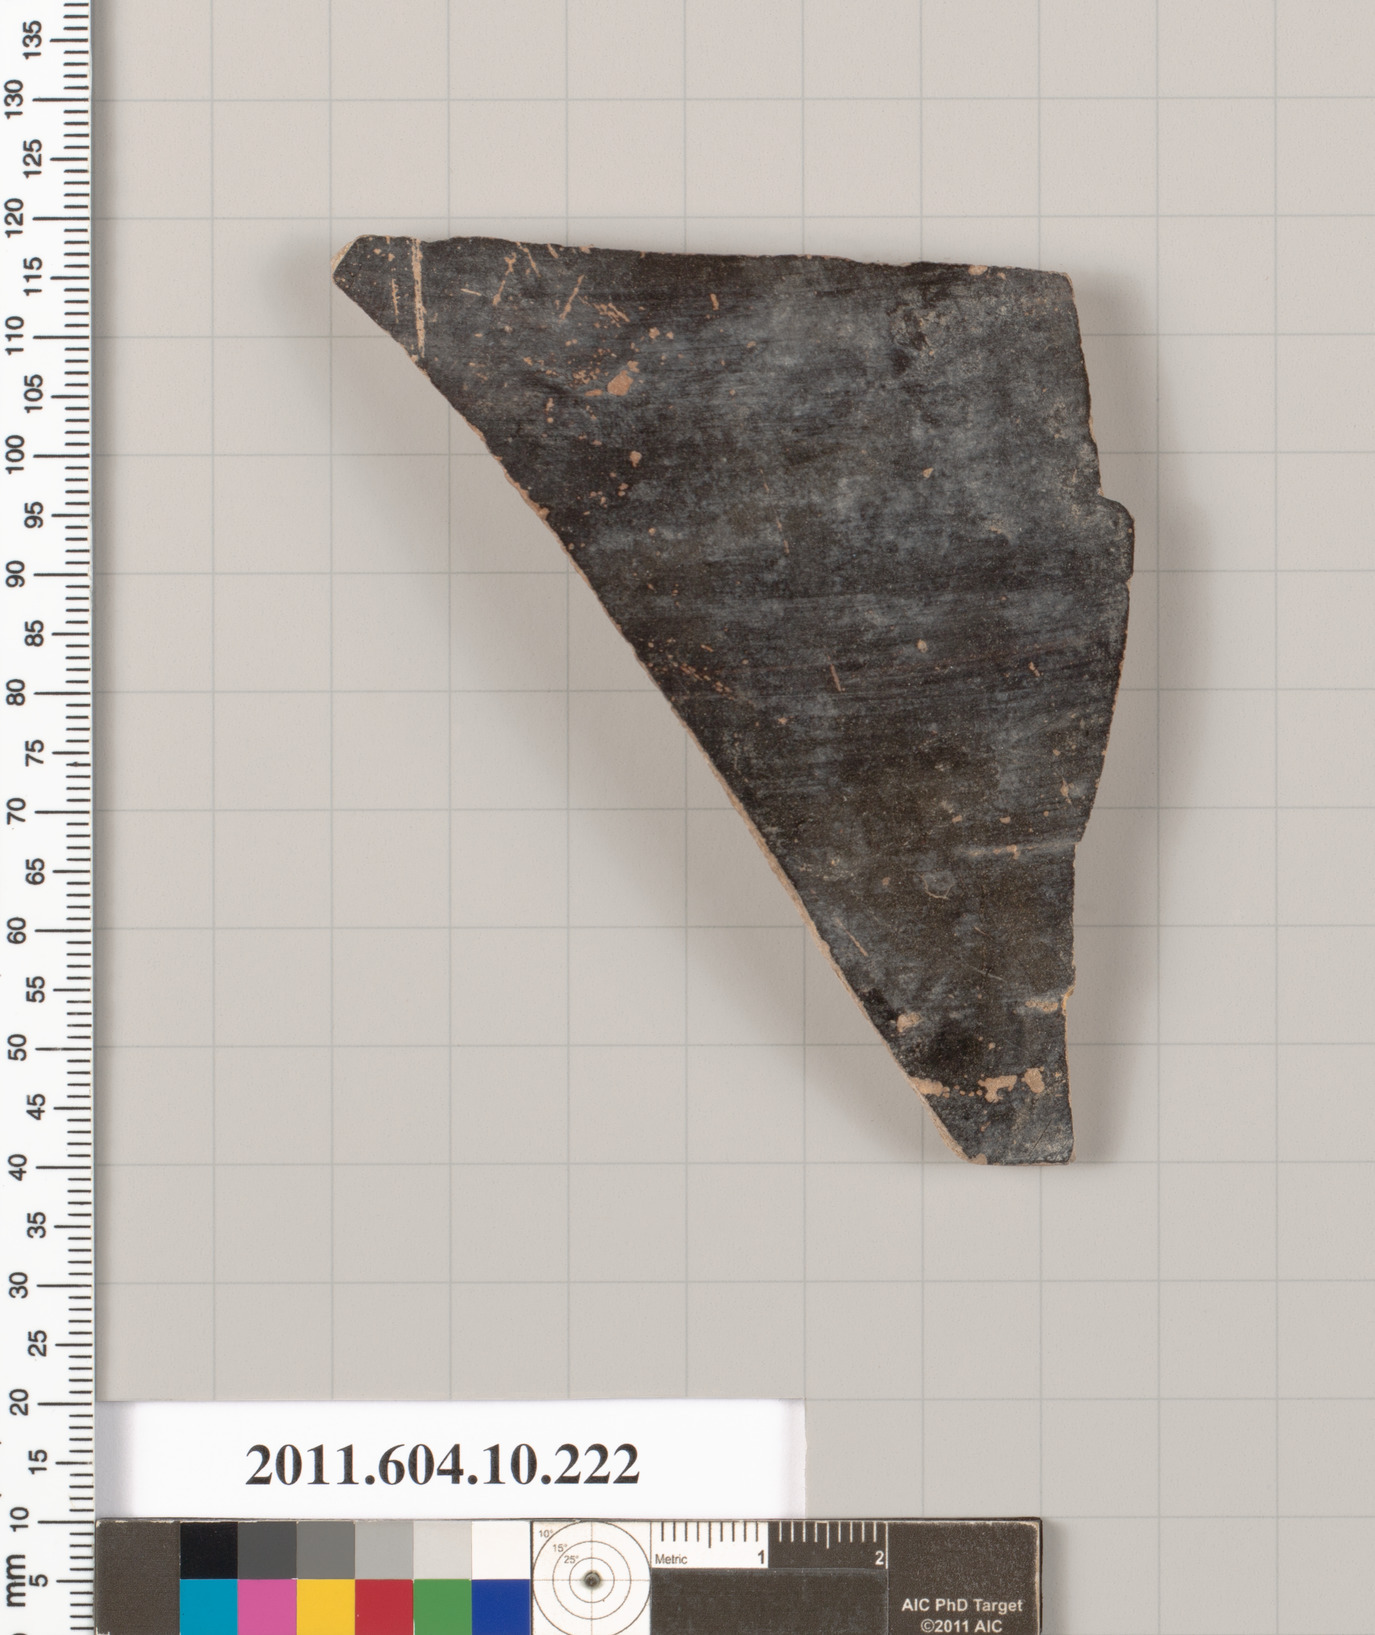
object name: undetermined closed shape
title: Terracotta fragment of a closed shape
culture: etruscan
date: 601-700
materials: terracotta